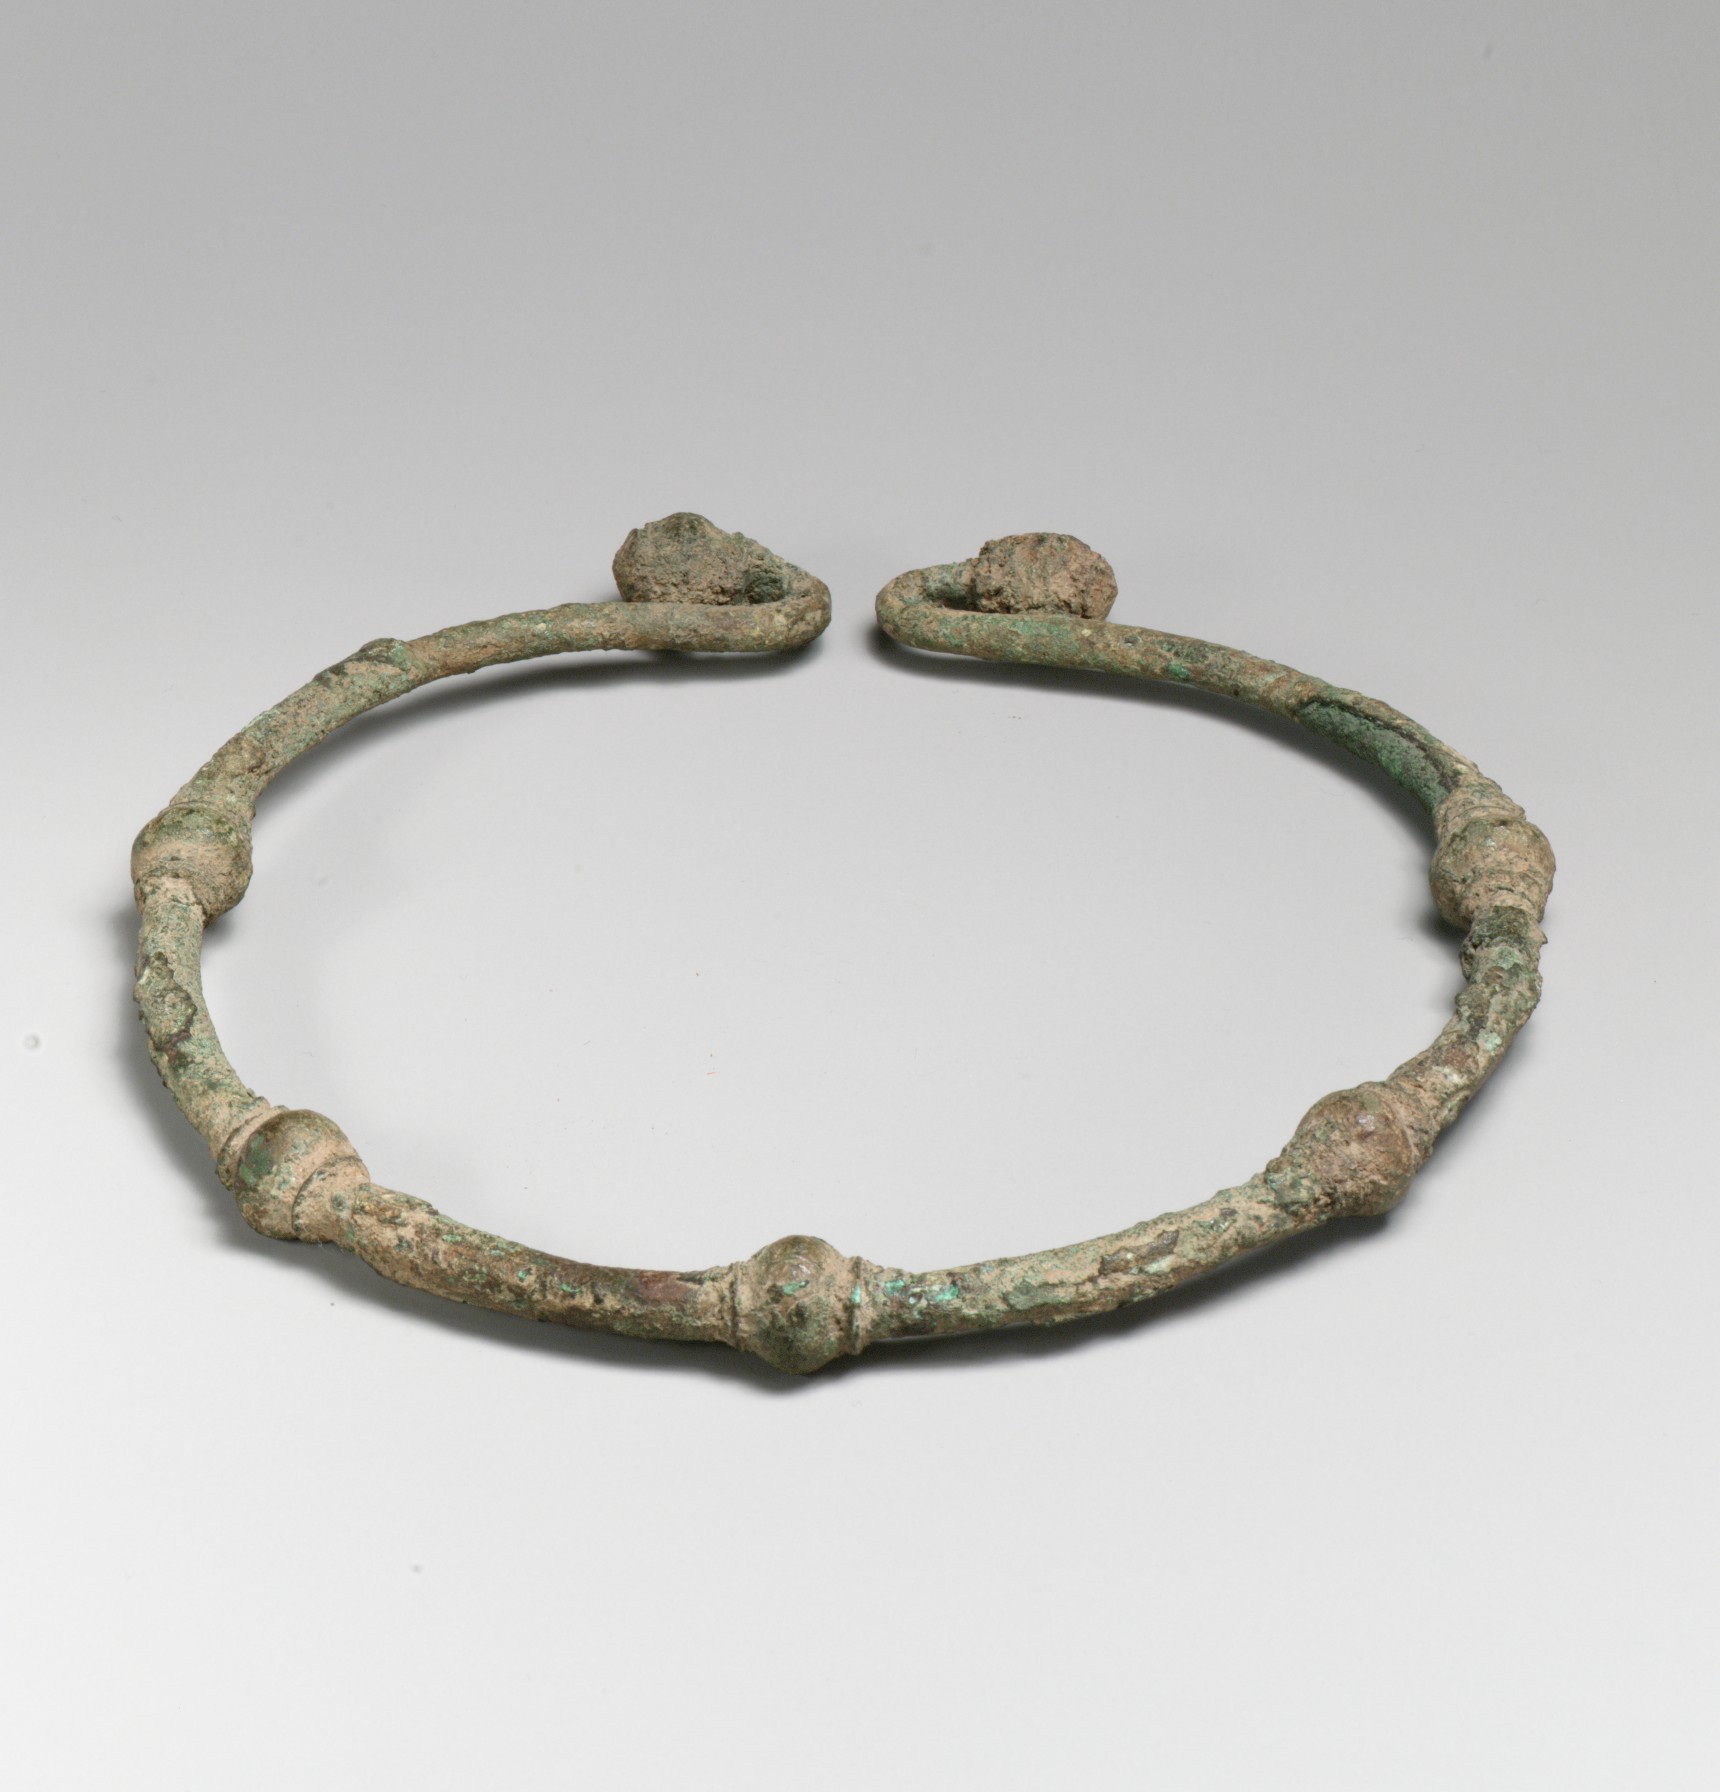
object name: necklace or neck ring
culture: italic or roman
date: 600 BCE-200 CE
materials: bronze